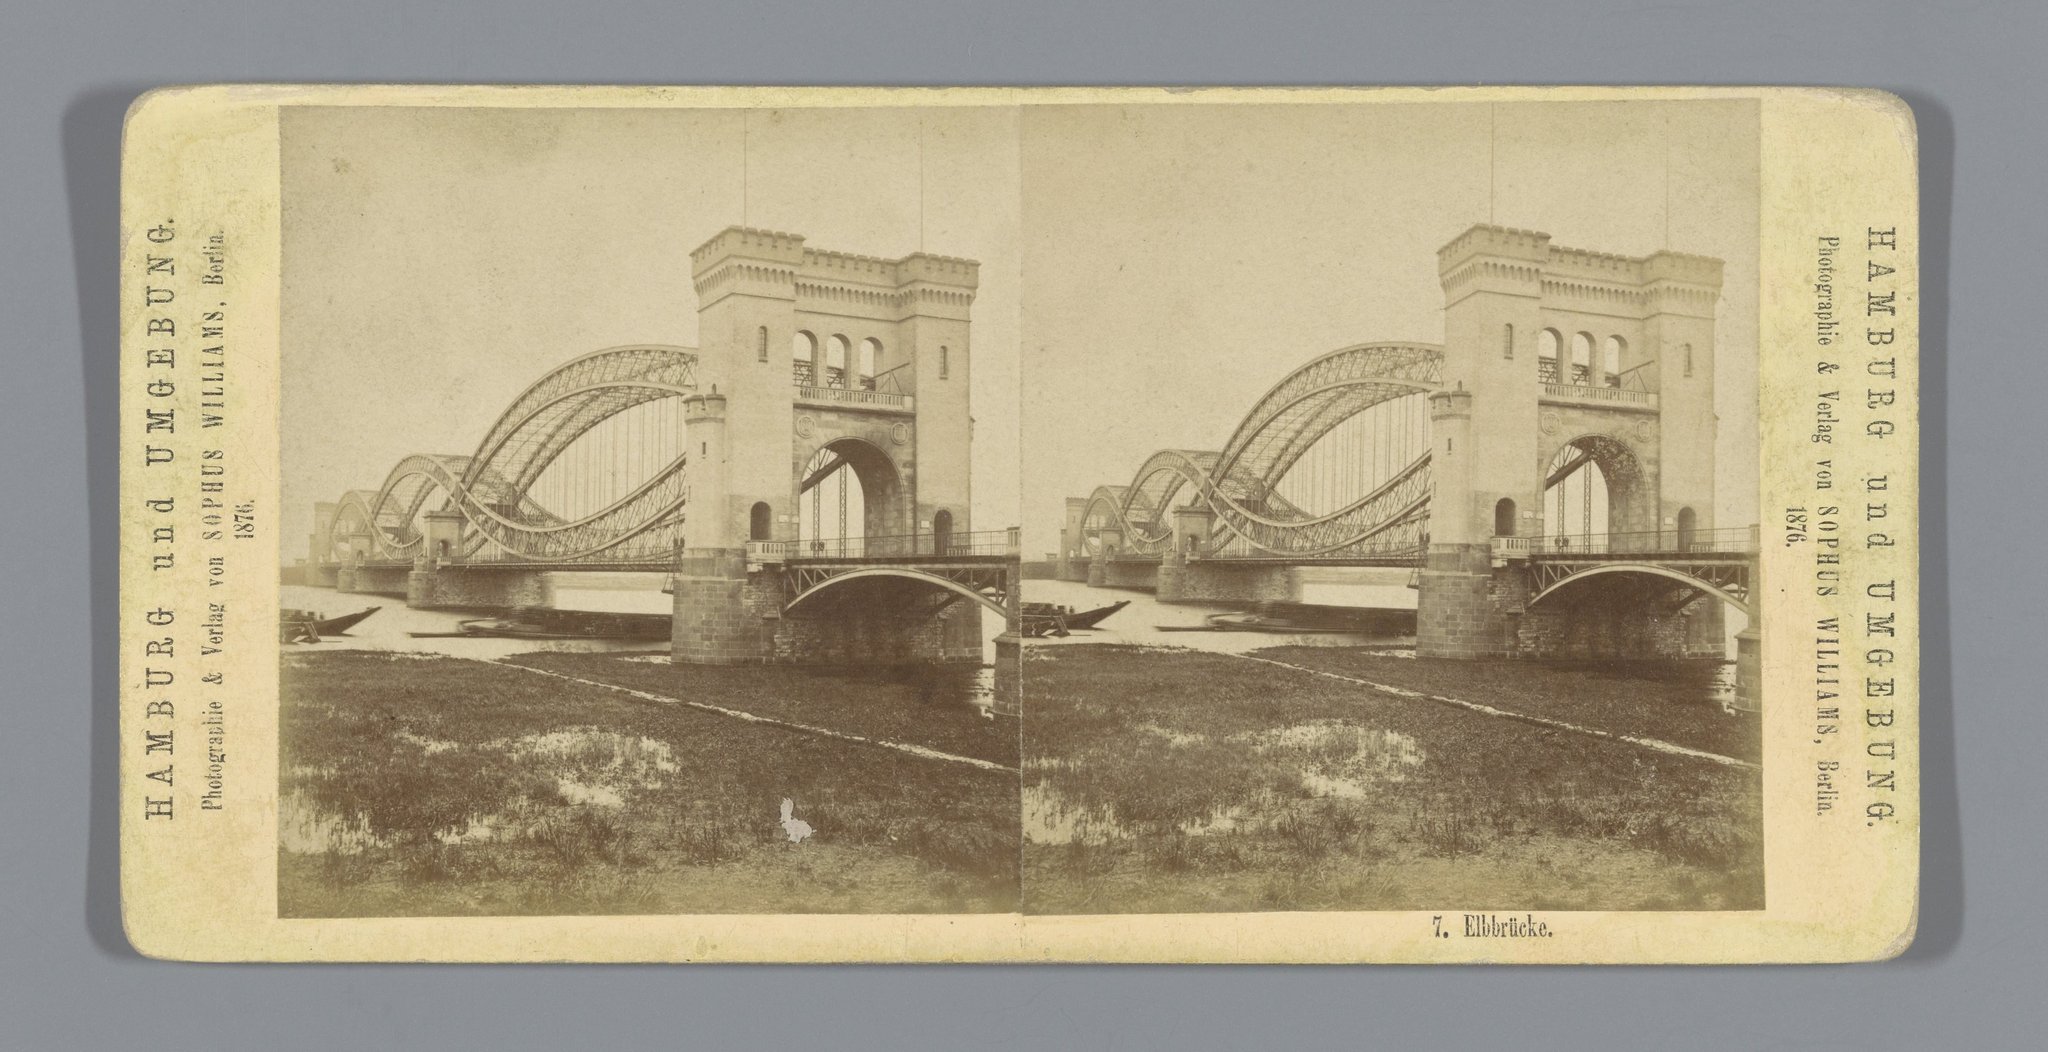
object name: stereograph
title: Hamburg und Umgebung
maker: sophus williams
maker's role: publisher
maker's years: 1835-1900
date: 1876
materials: cardboard, photographic support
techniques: albumen print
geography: berlin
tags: bridge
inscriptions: number: ‘7.’